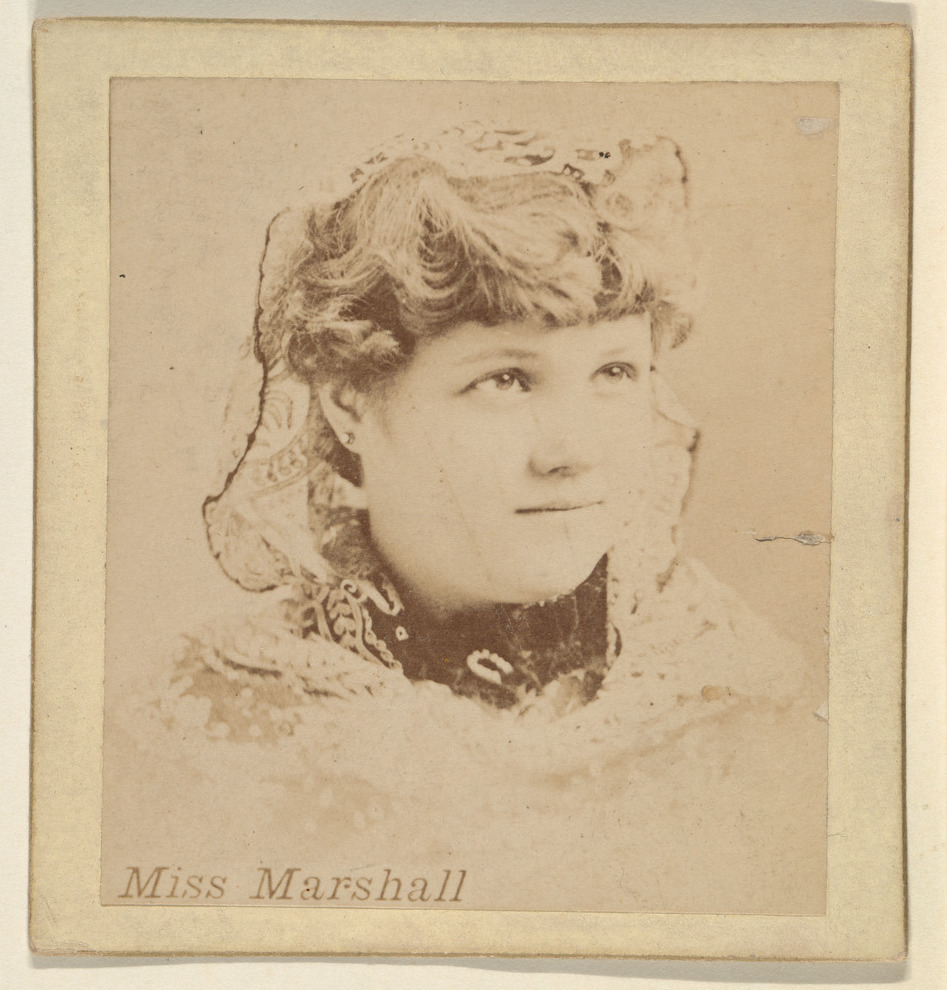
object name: photograph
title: Miss Marshall, from the Actresses series (N246), Type 2, issued by Kinney Brothers to promote Sporting Extra Cigarettes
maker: kinney brothers tobacco company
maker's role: publisher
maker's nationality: american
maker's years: 1869-2011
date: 1890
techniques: albumen silver print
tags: portraits,women,actresses